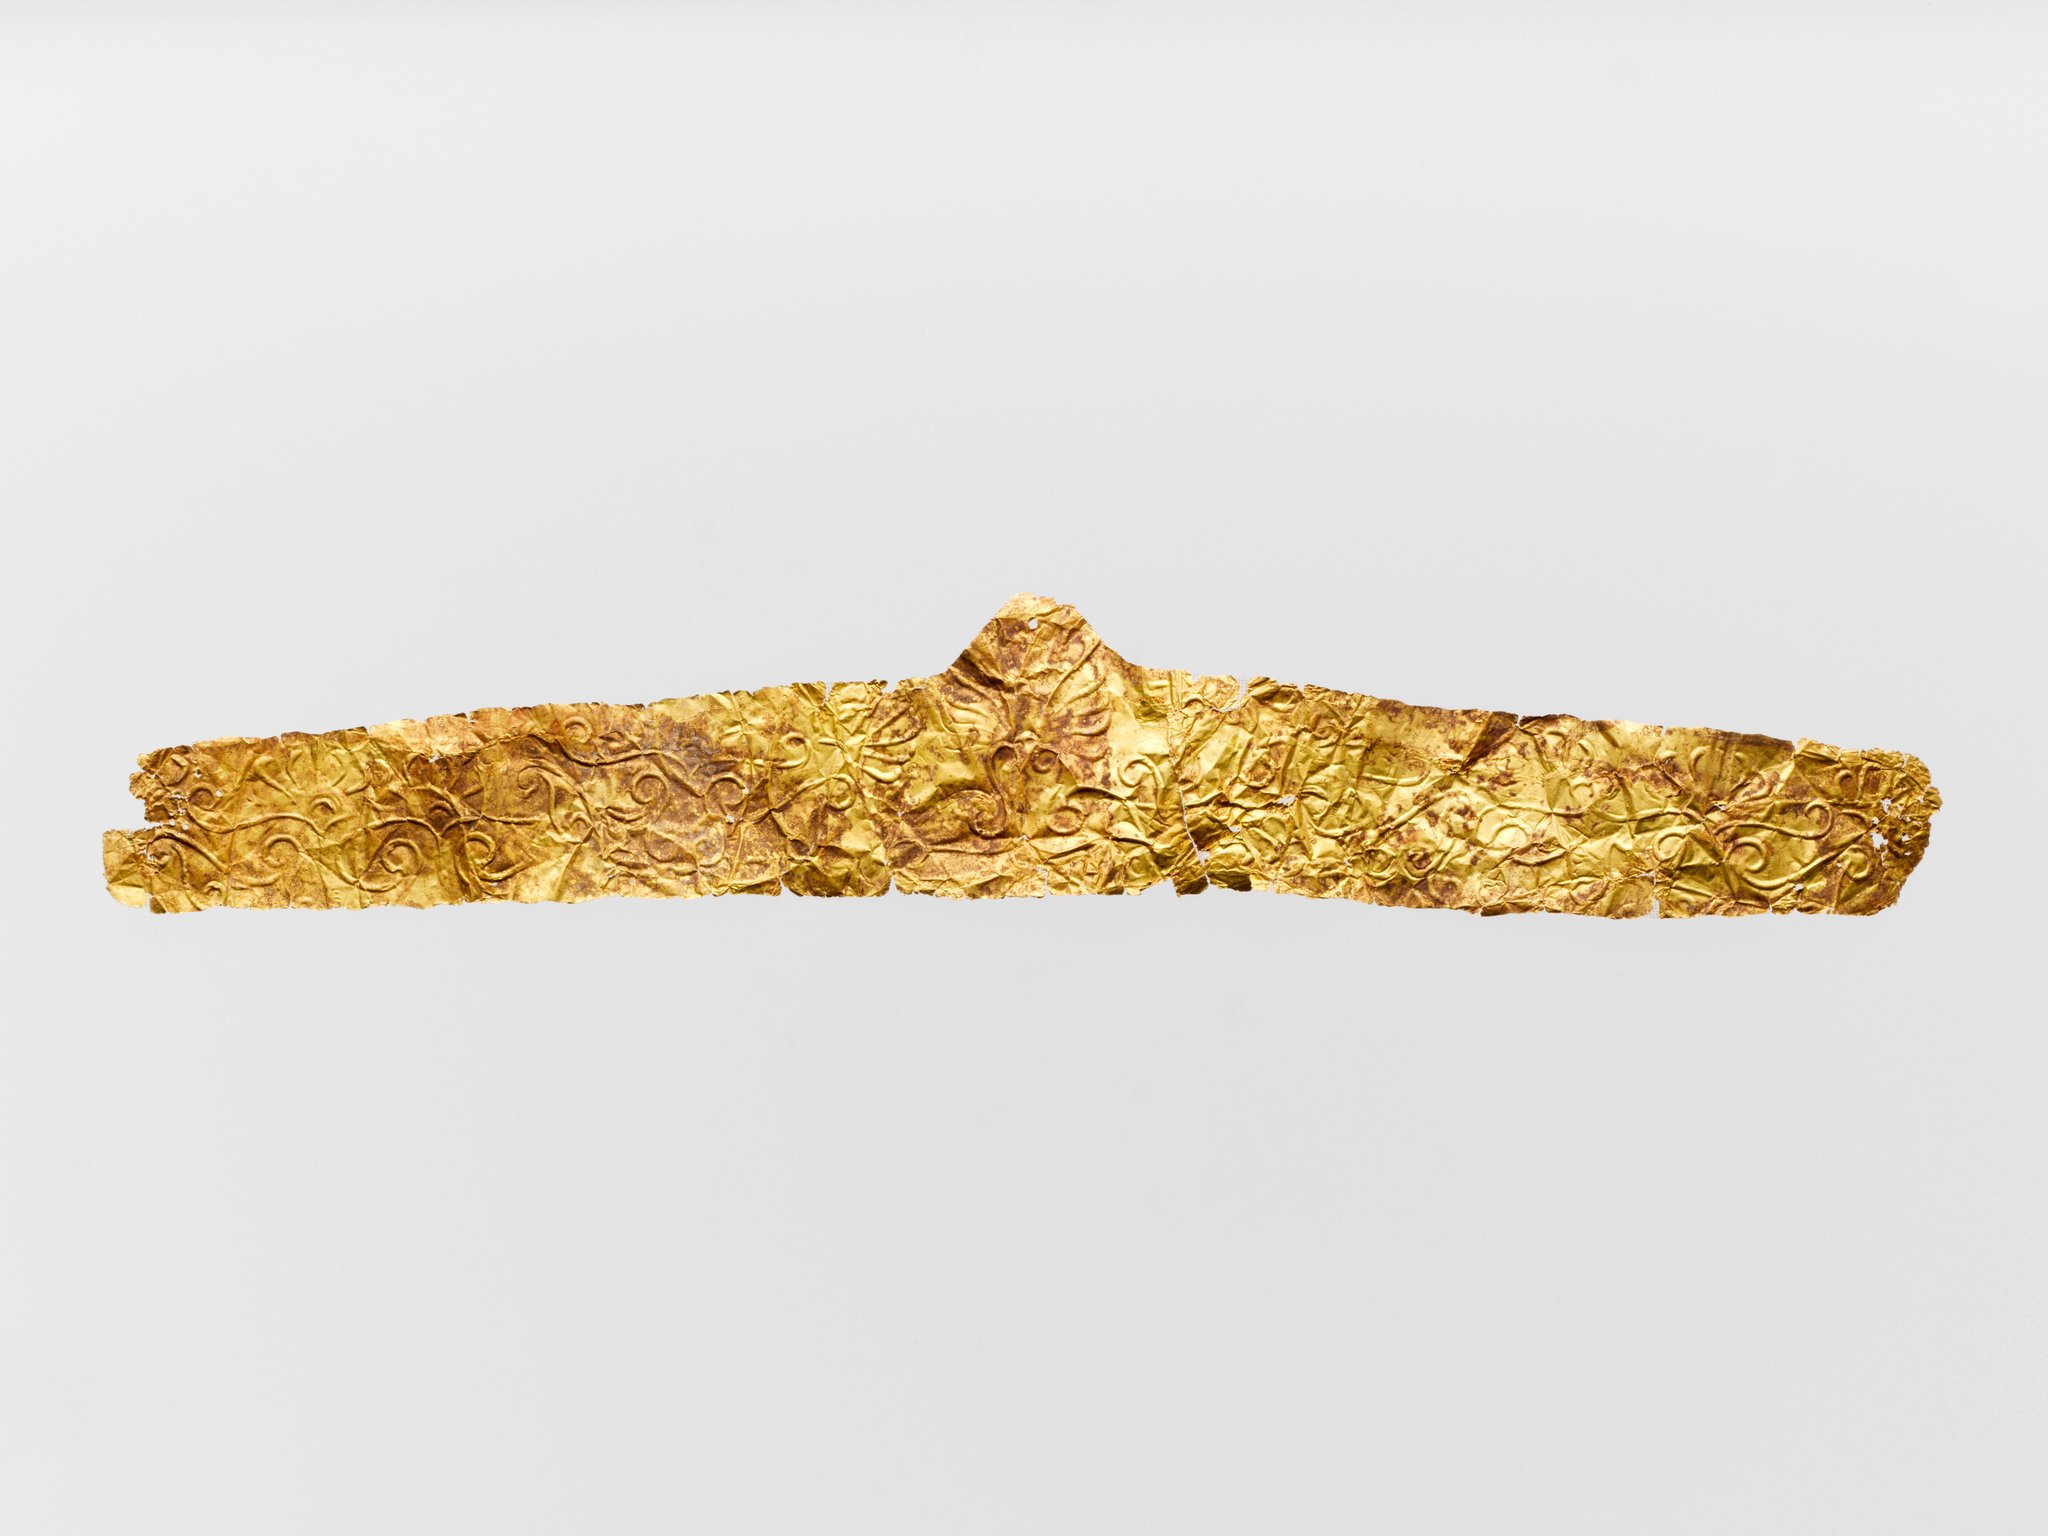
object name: diadem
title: Gold diadem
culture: cypriot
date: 400-301 BCE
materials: gold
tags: diadems